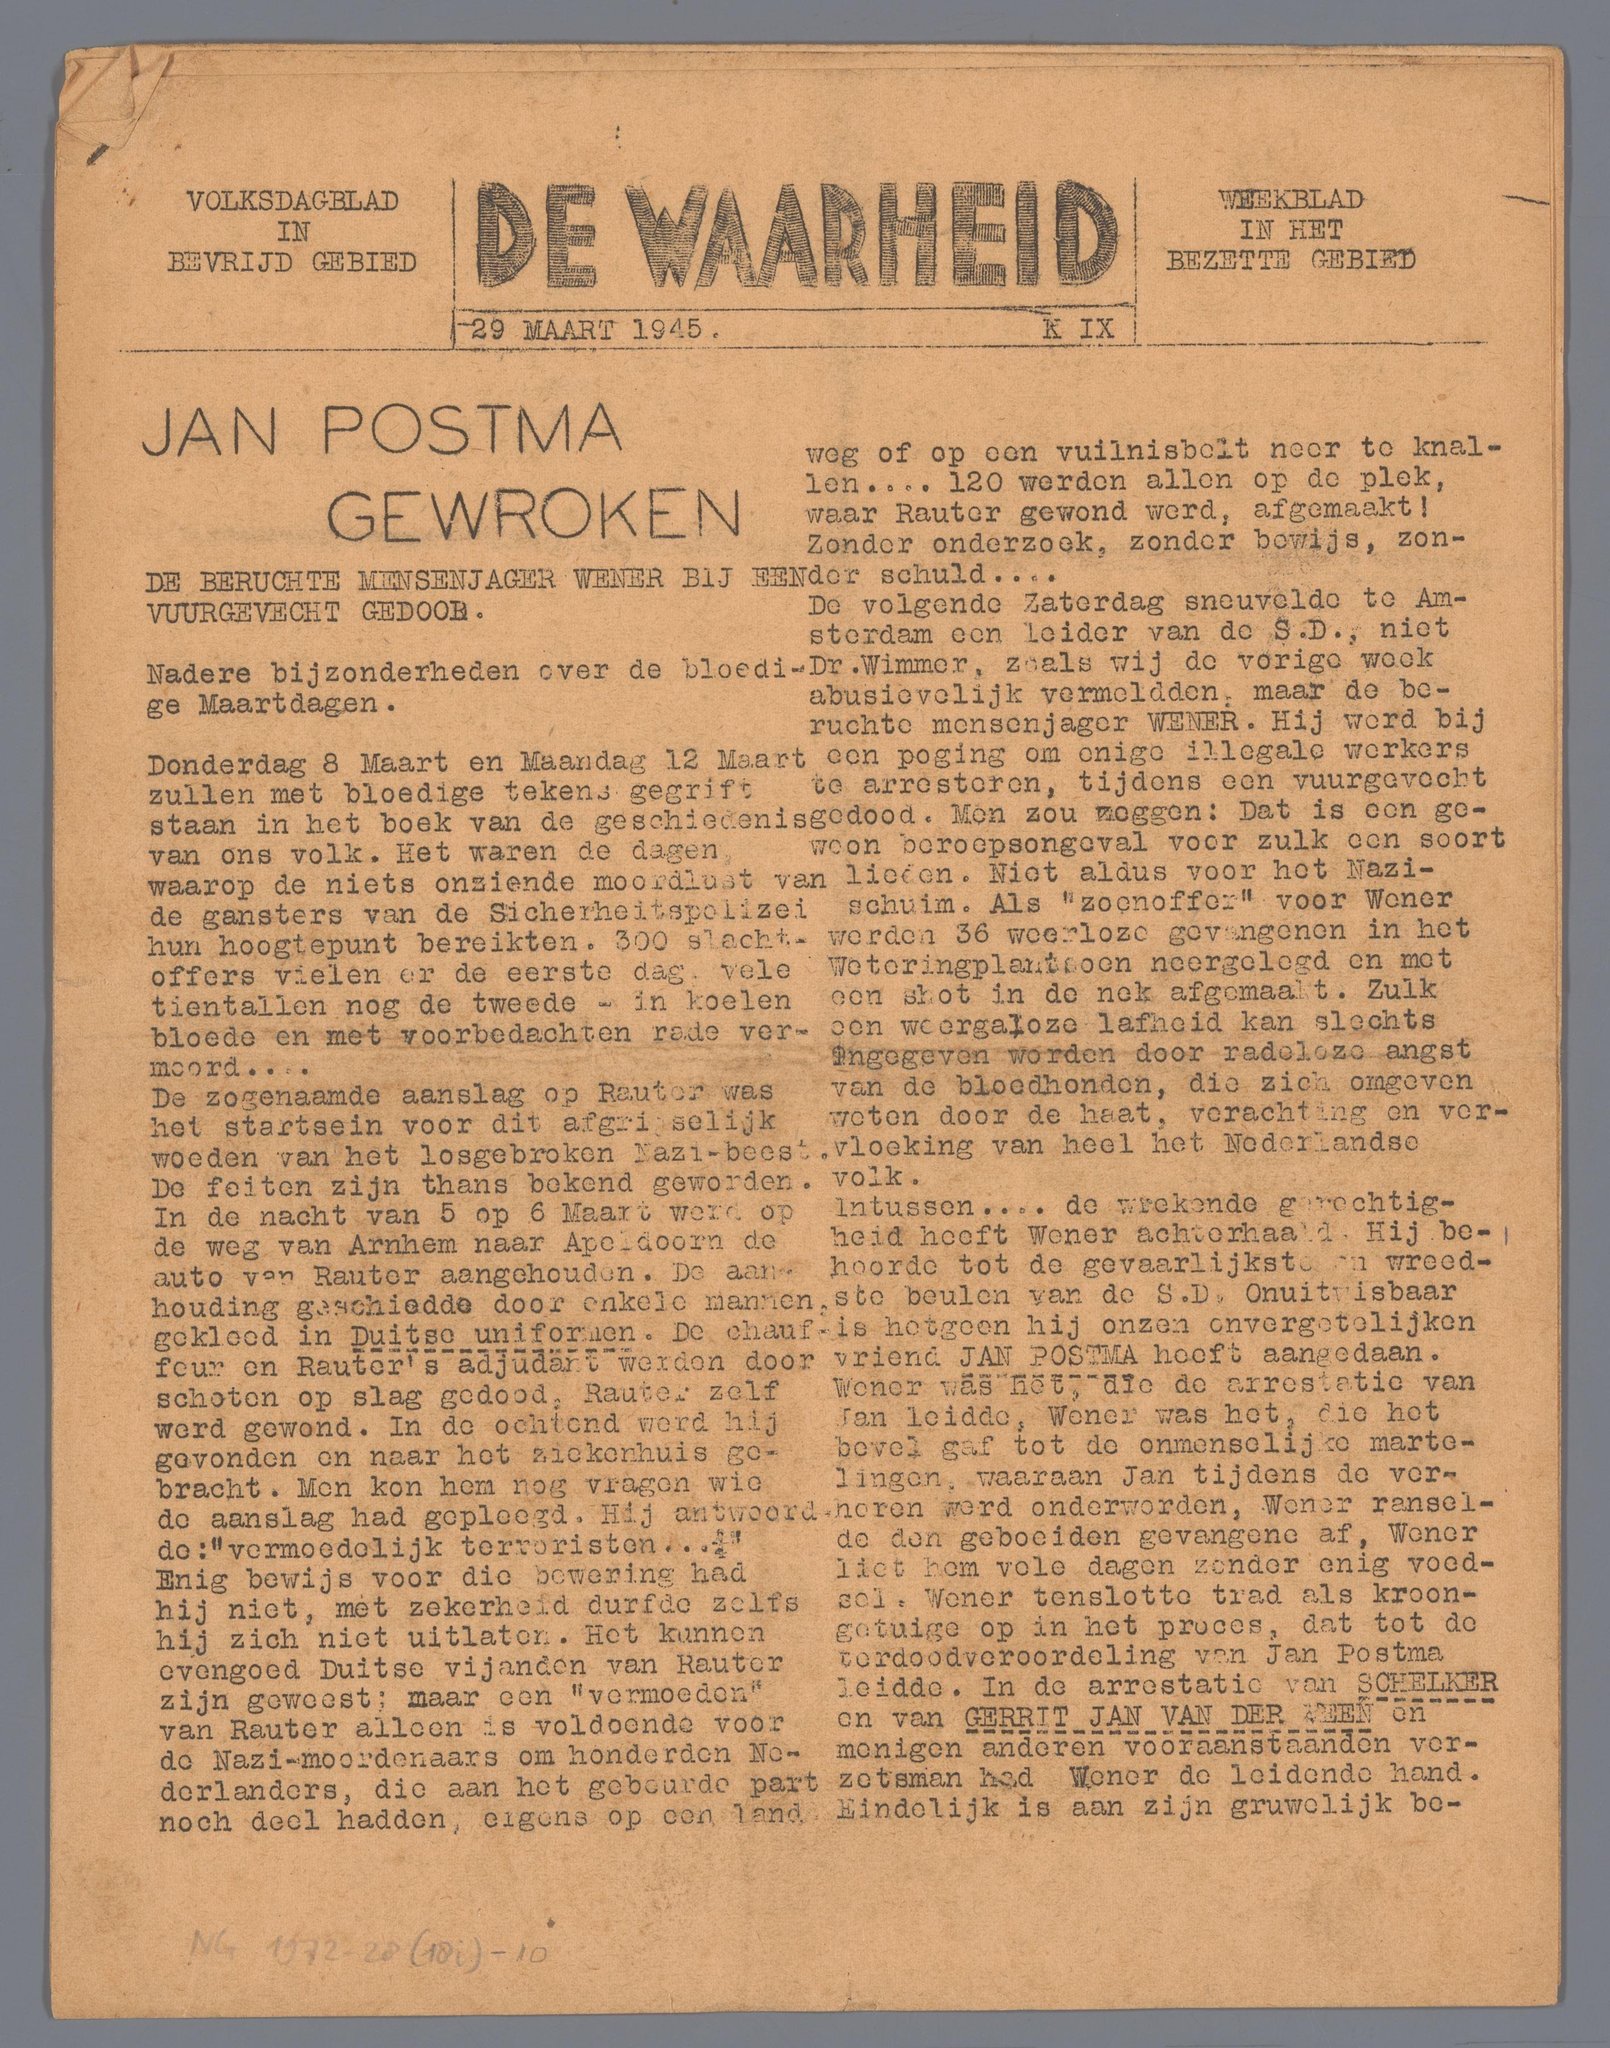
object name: newspaper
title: De Waarheid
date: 1945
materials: paper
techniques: mimeography, printing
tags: netherlands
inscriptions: date